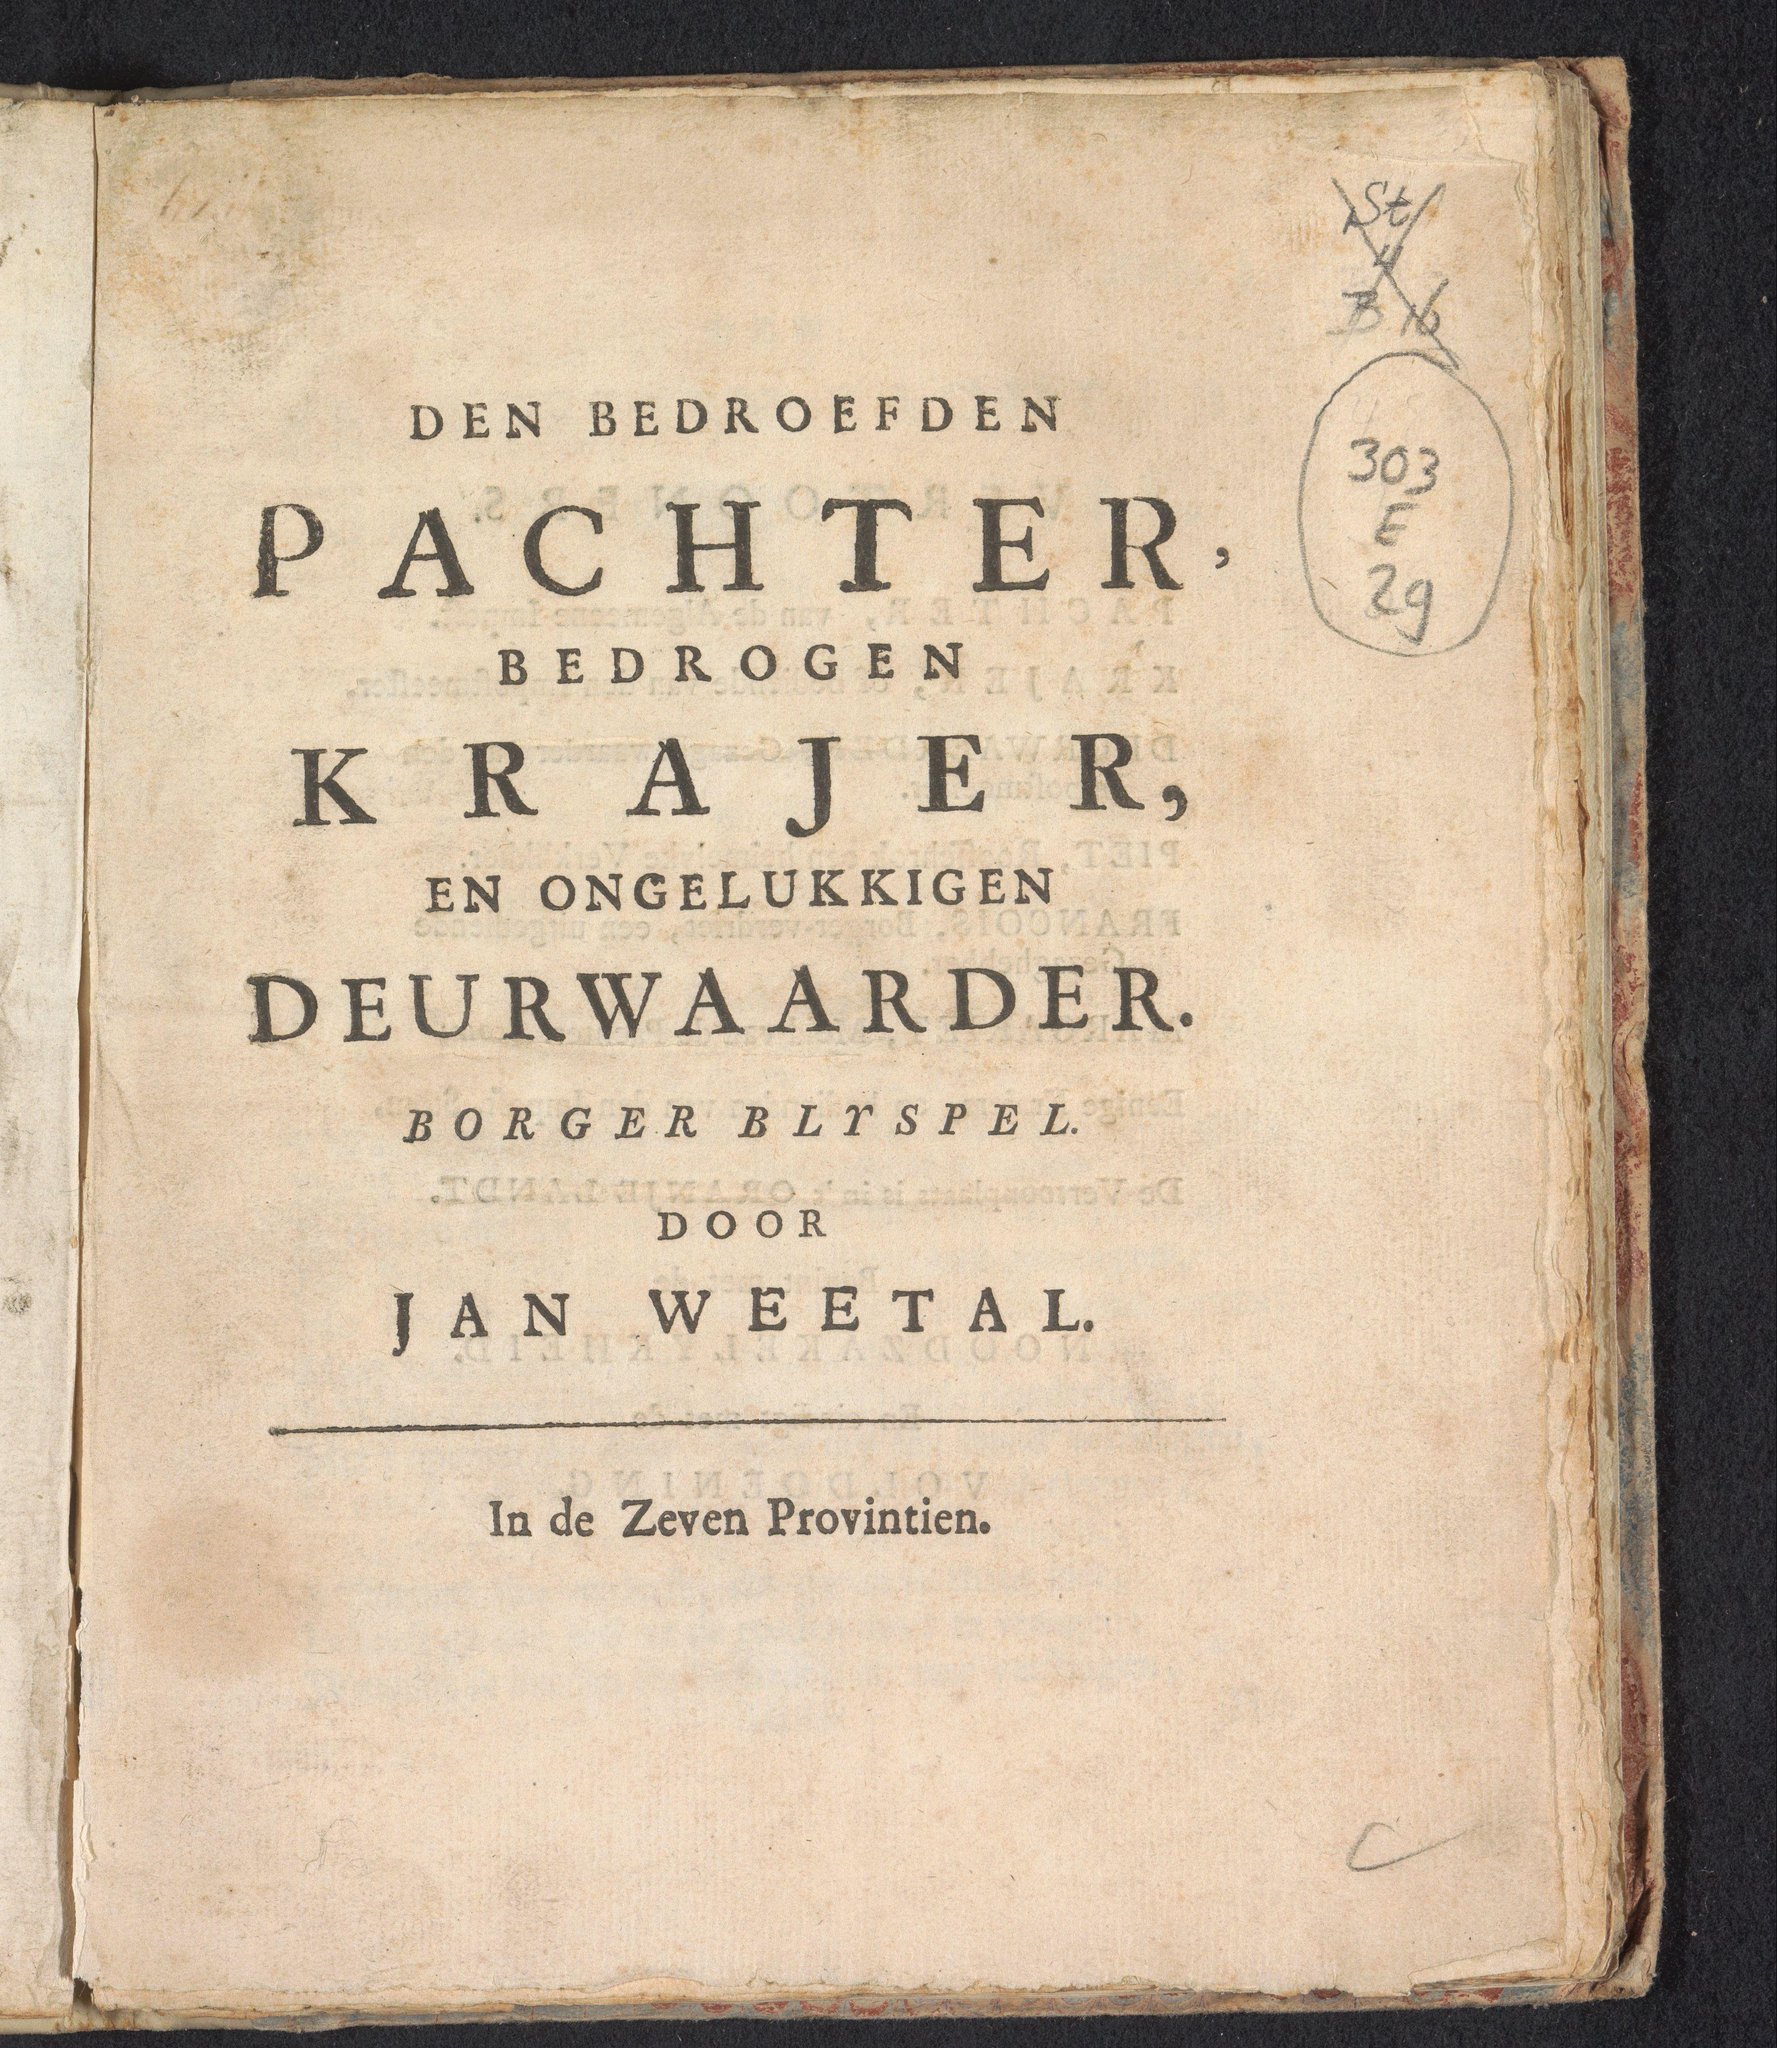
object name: titelblad, titelpagina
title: Titelpagina van: Jan Weetal, Den Bedroefden Pachter (...), 1748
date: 1748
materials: paper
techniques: engraving, etching, letterpress printing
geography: harderwijk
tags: bladder with peas ~ children's games, owls, rodents: rabbit, amsterdam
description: Titelpagina van het boekje: Den bedroefden pachter bedrogen krajer, en ongelukkigen deurwaarder. borger blyspel , door Jan Weetal, 1748. Titel met allegorisch vignet van een helm waarin een uil zit, geflankeerd door twee konijnen, links een putto met een varkensblaas met erwten, onderaan de motto: Schrik Niet.